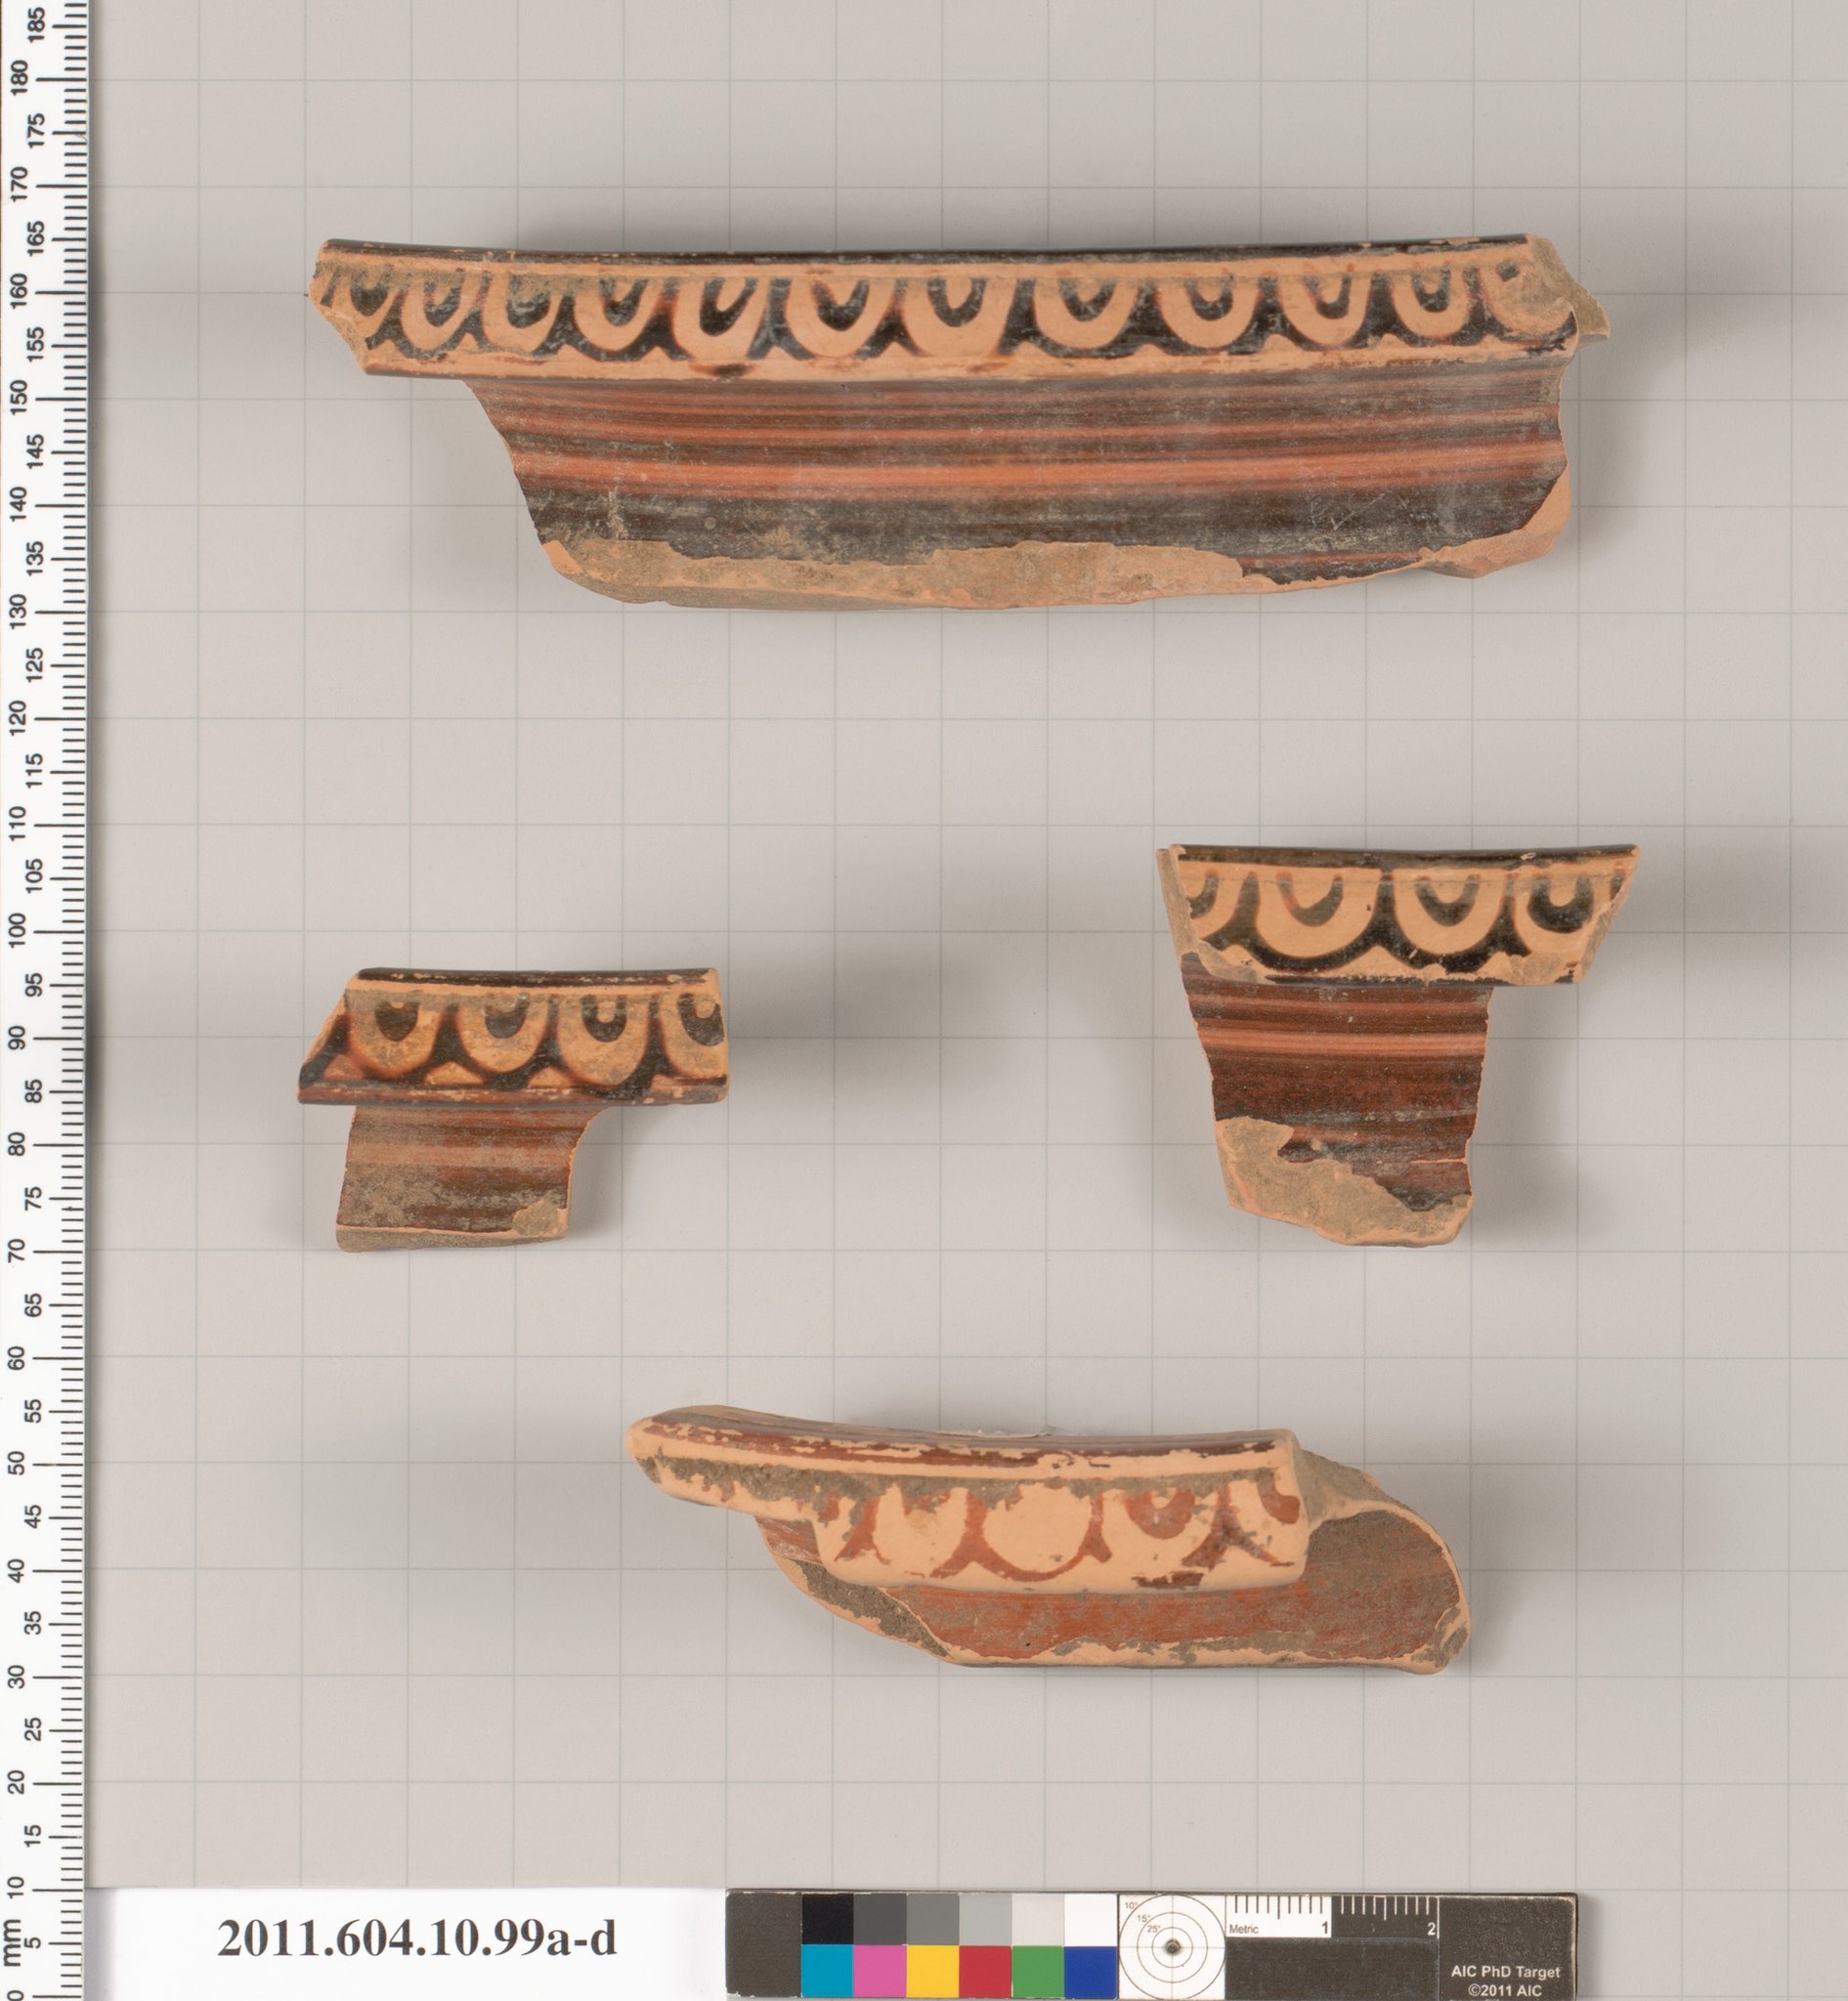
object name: stamnos fragment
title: Terracotta fragments of a stamnos (jar)?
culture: etruscan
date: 400-301 BCE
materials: terracotta